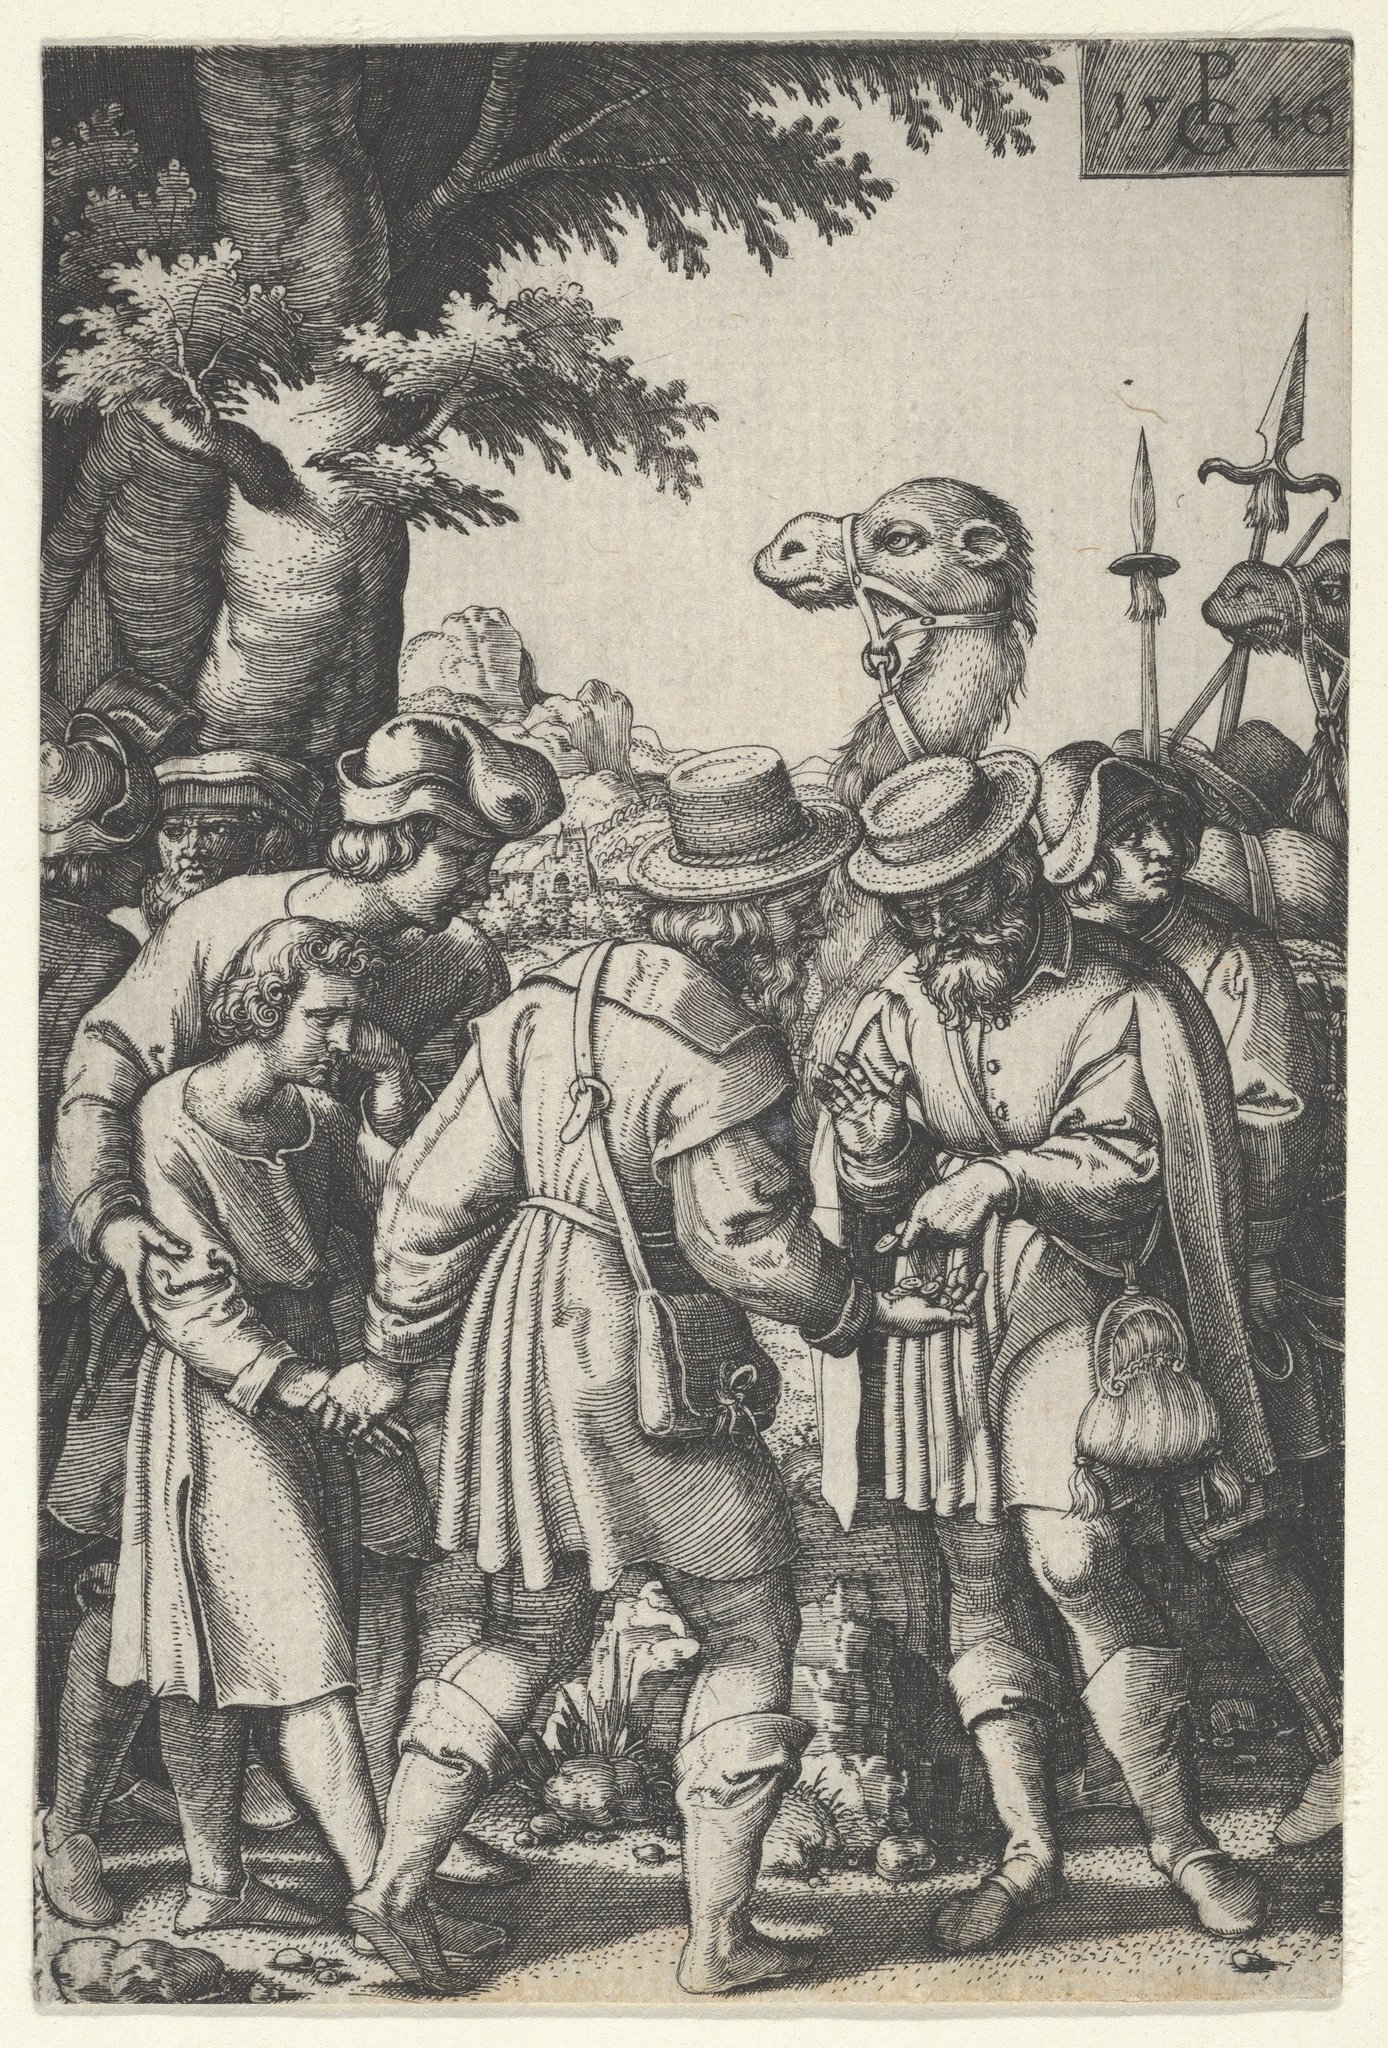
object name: print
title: Joseph Sold to the Merchants, from The Story of Joseph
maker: georg pencz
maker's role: artist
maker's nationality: german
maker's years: 1500-1550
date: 1546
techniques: engraving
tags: boys,men,camels